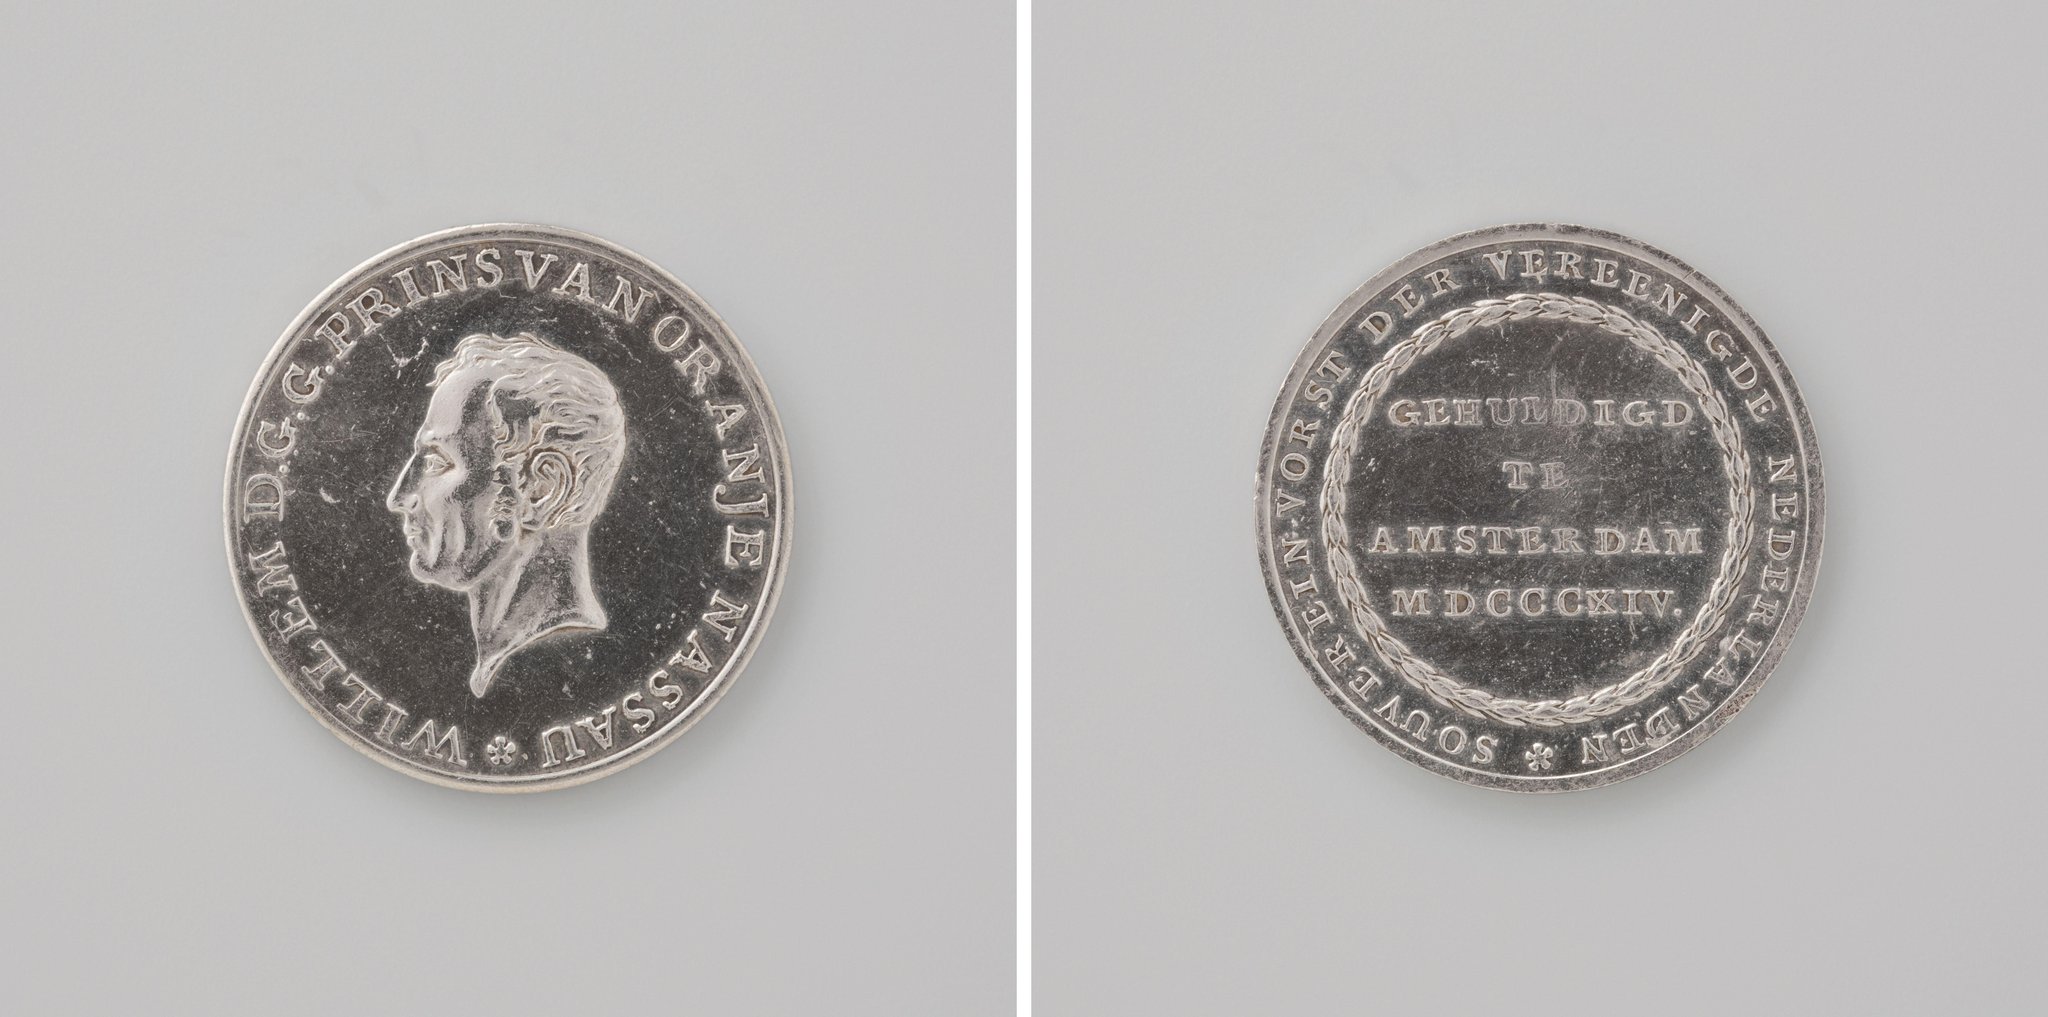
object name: strooipenning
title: Inhuldiging te Amsterdam van Willem Frederik, prins van Oranje als souverein vorst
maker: hendrik lageman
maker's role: draughtsman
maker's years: 1765-1816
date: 1814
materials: silver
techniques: striking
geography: netherlands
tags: the hague, berlin, william i of the netherlands, netherlands, amsterdam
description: Zilveren penning. Voorzijde: borststuk man binnen omschrift. Keerzijde: opschrift binnen omschrift